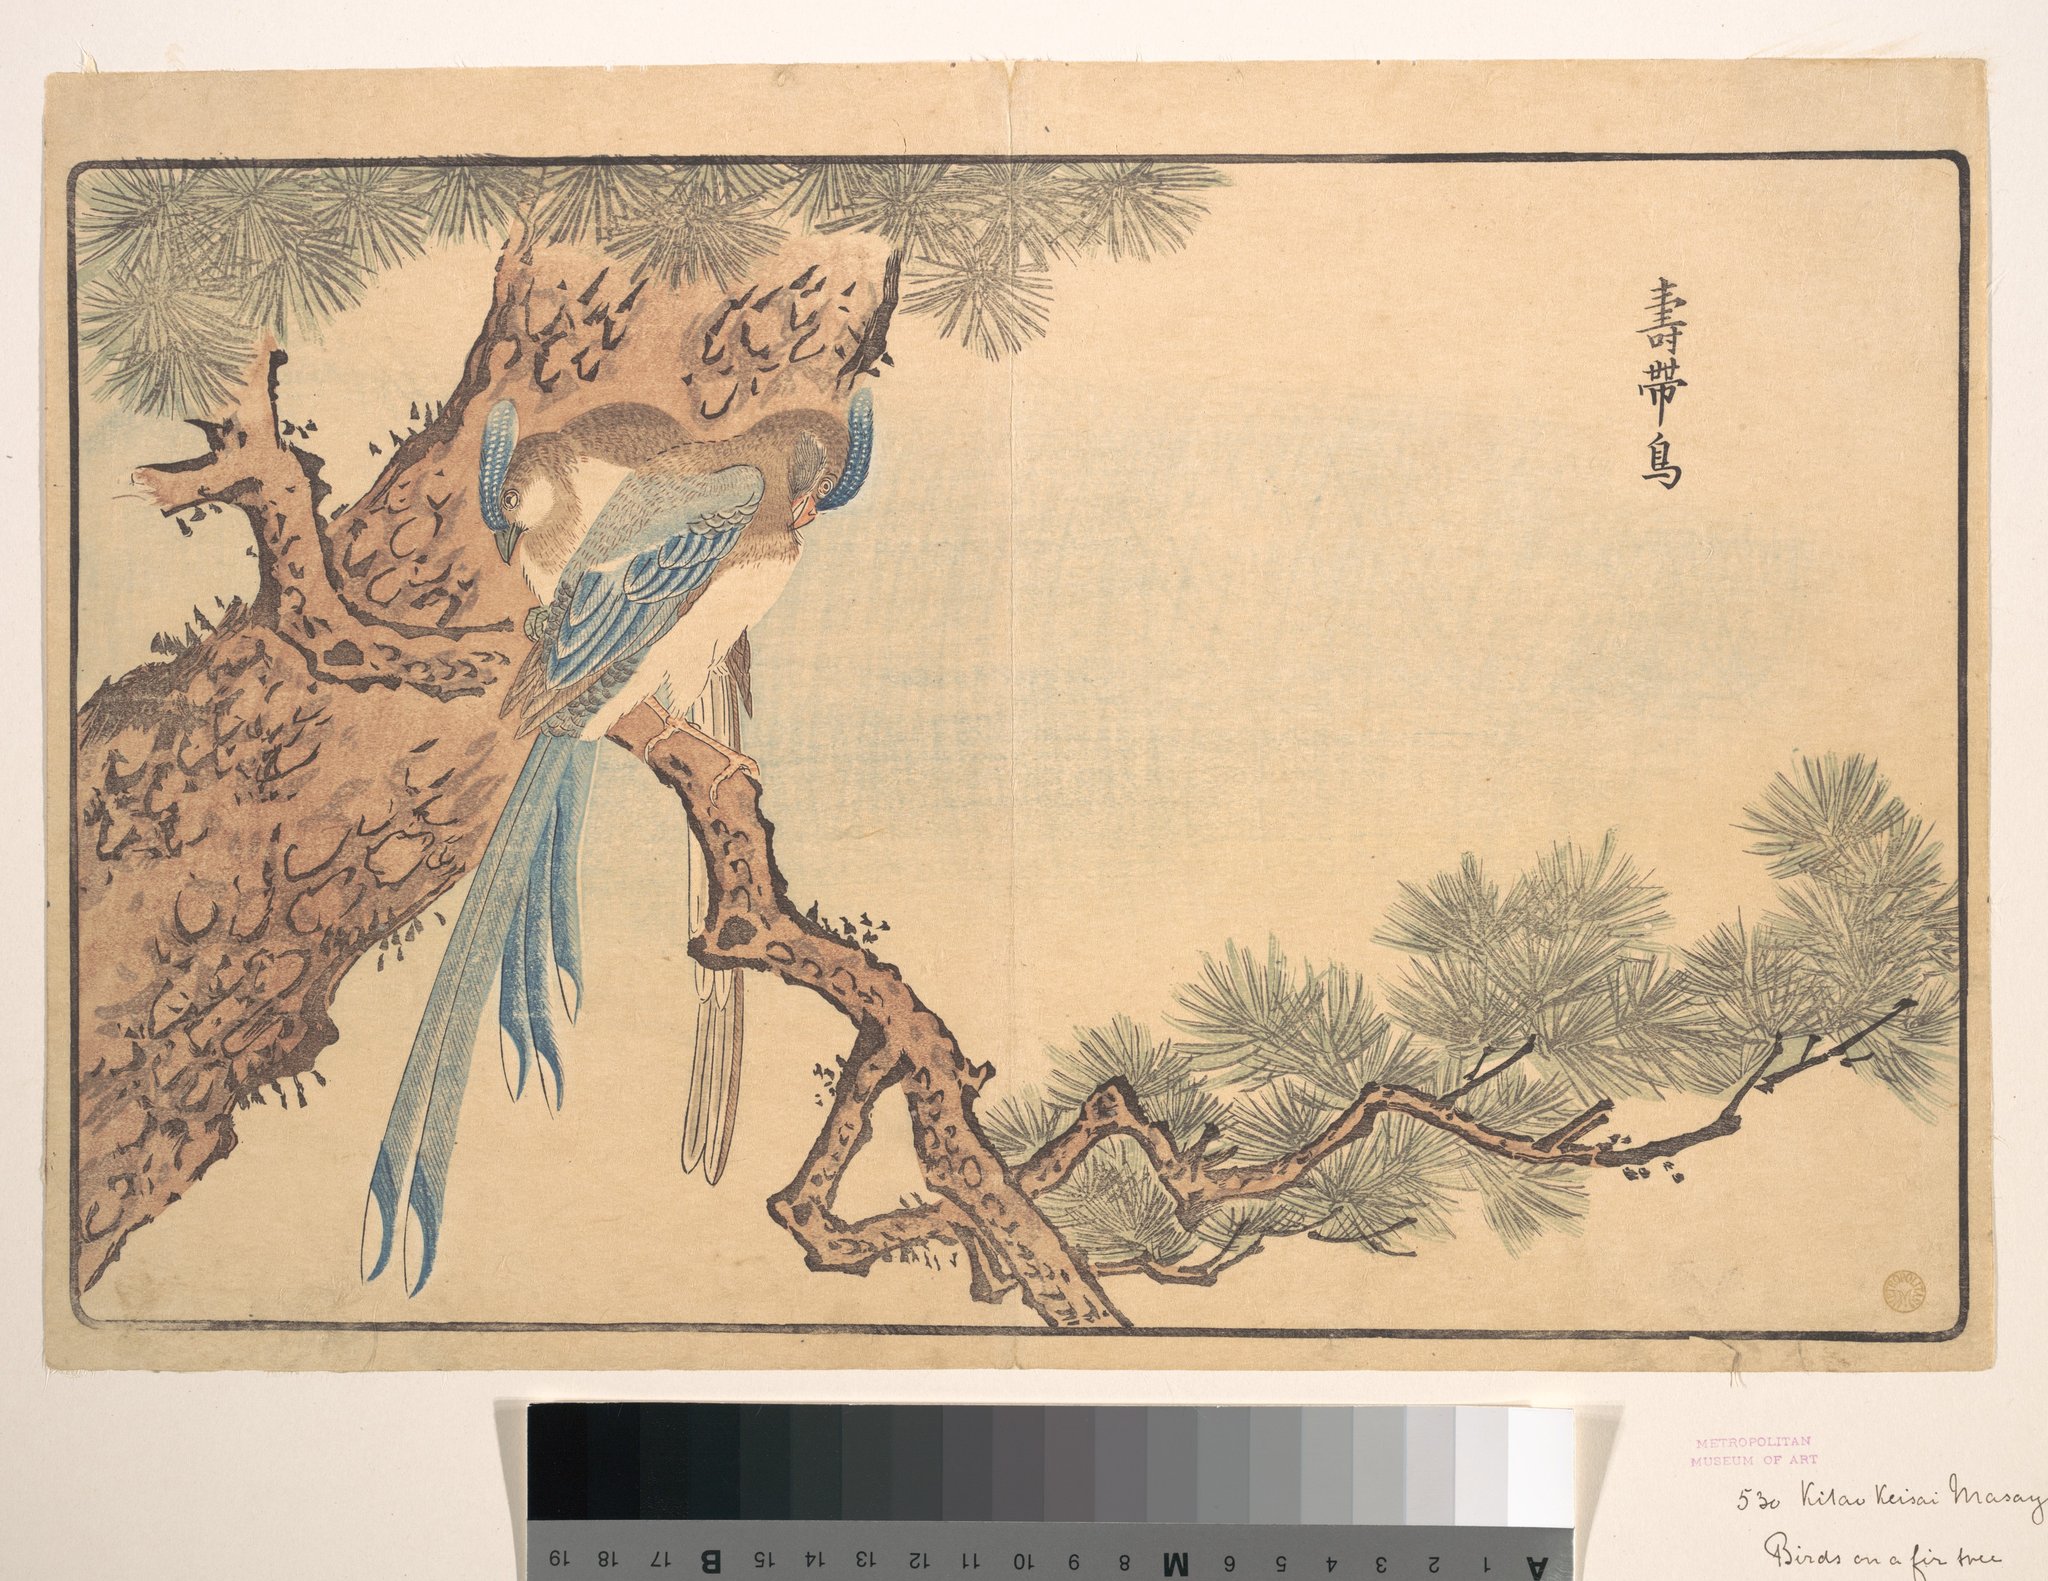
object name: print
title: Paradise Fly-catcher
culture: japanese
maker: kuwagata keisai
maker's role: artist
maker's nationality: japanese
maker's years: 1764-1824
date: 1789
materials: ink, paper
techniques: woodblock print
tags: birds,trees